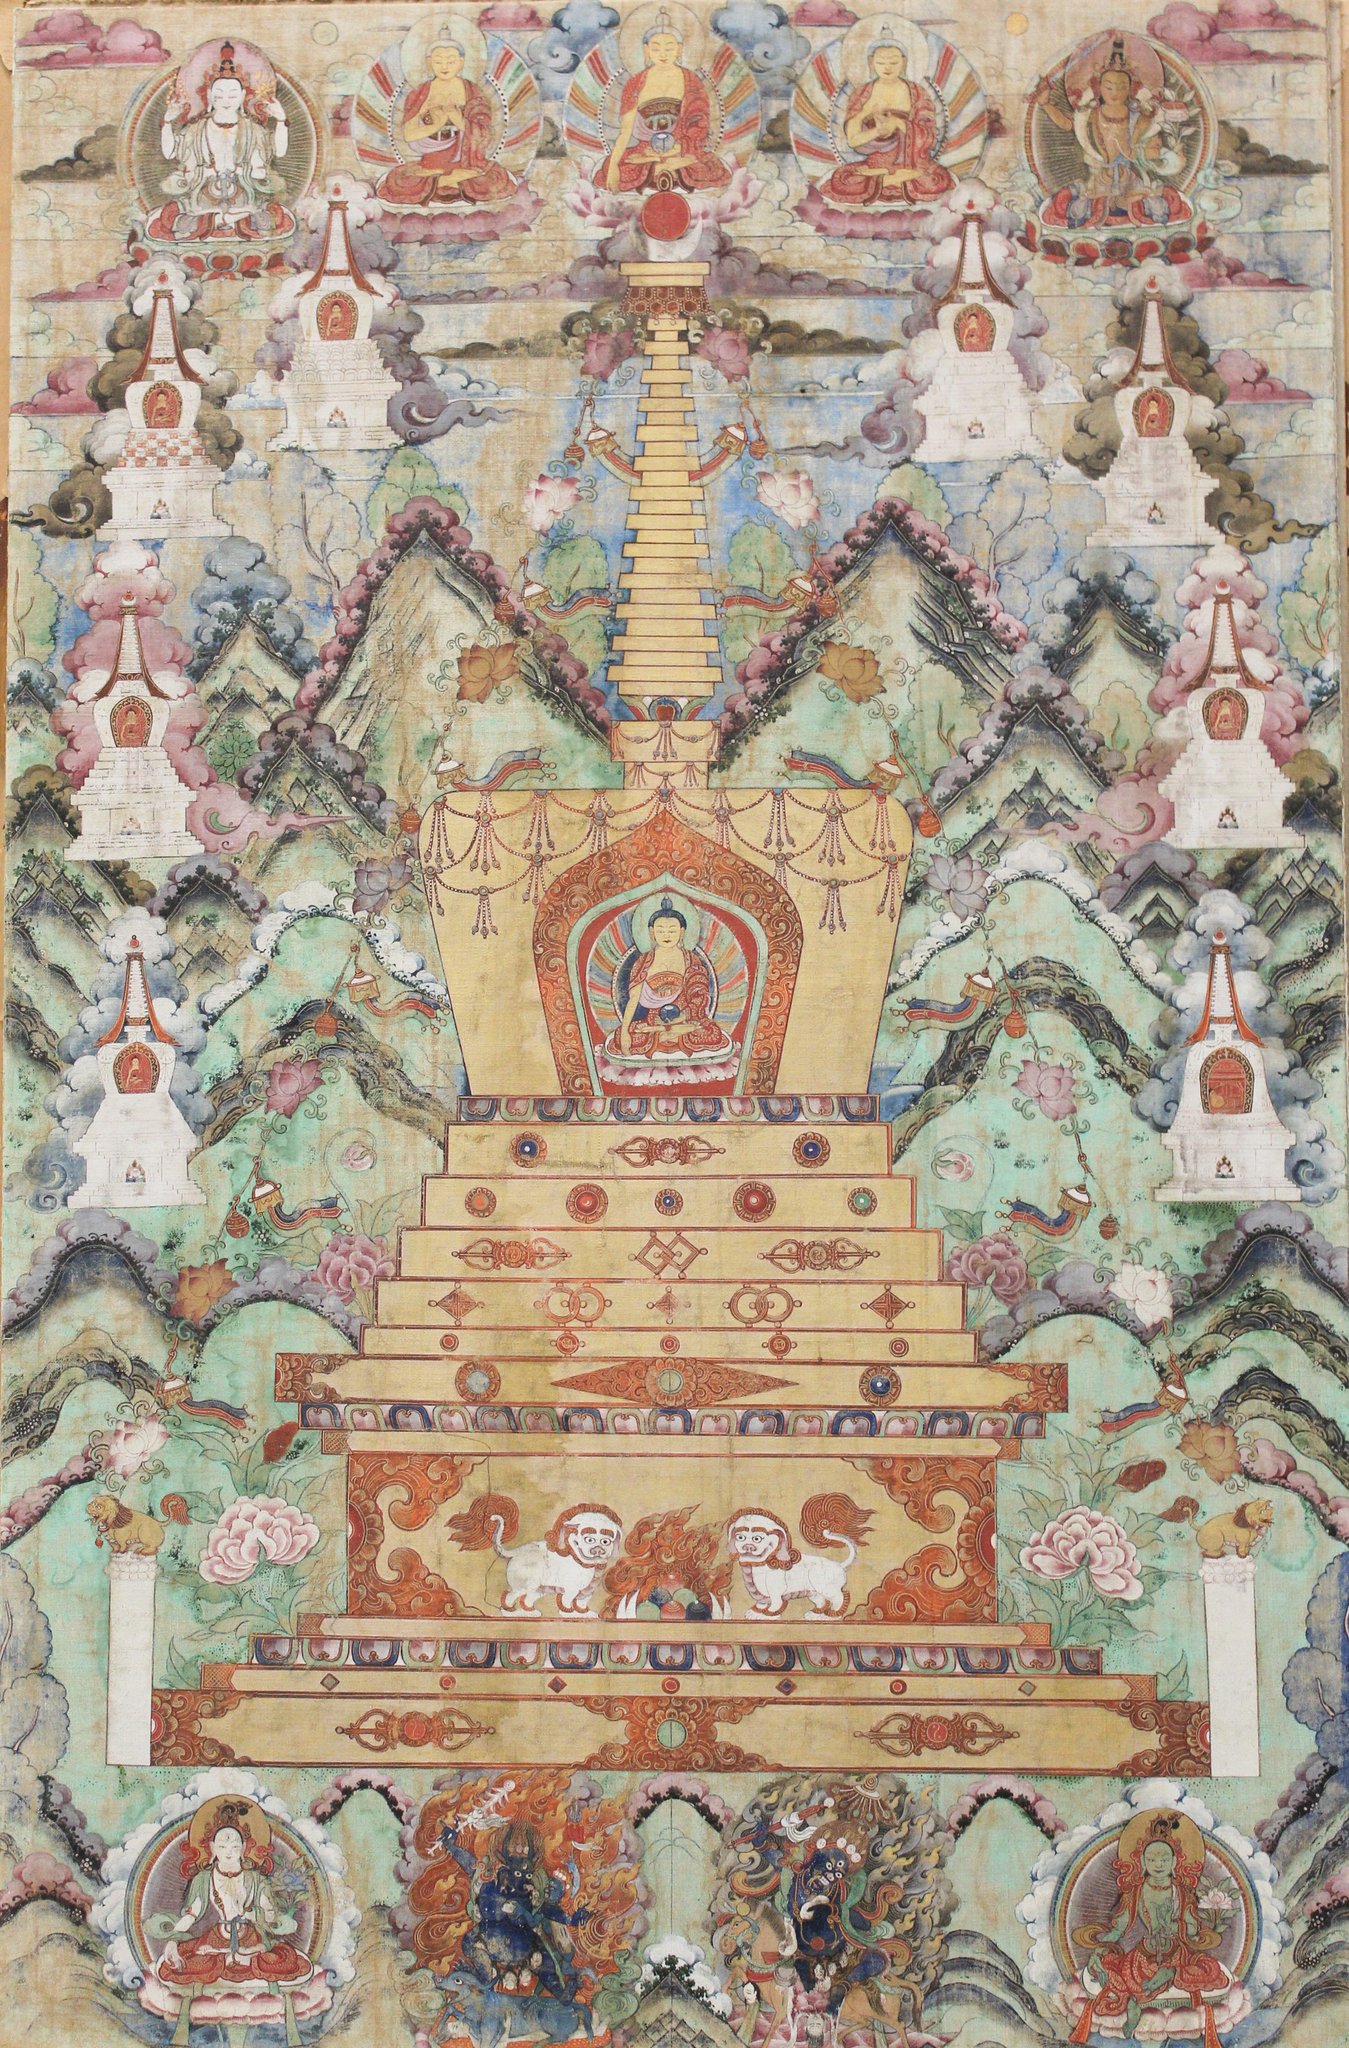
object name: painting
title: Buddha Within a Stupa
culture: tibetan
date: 1501-1700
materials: canvas, silk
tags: lions,buddha,stupas